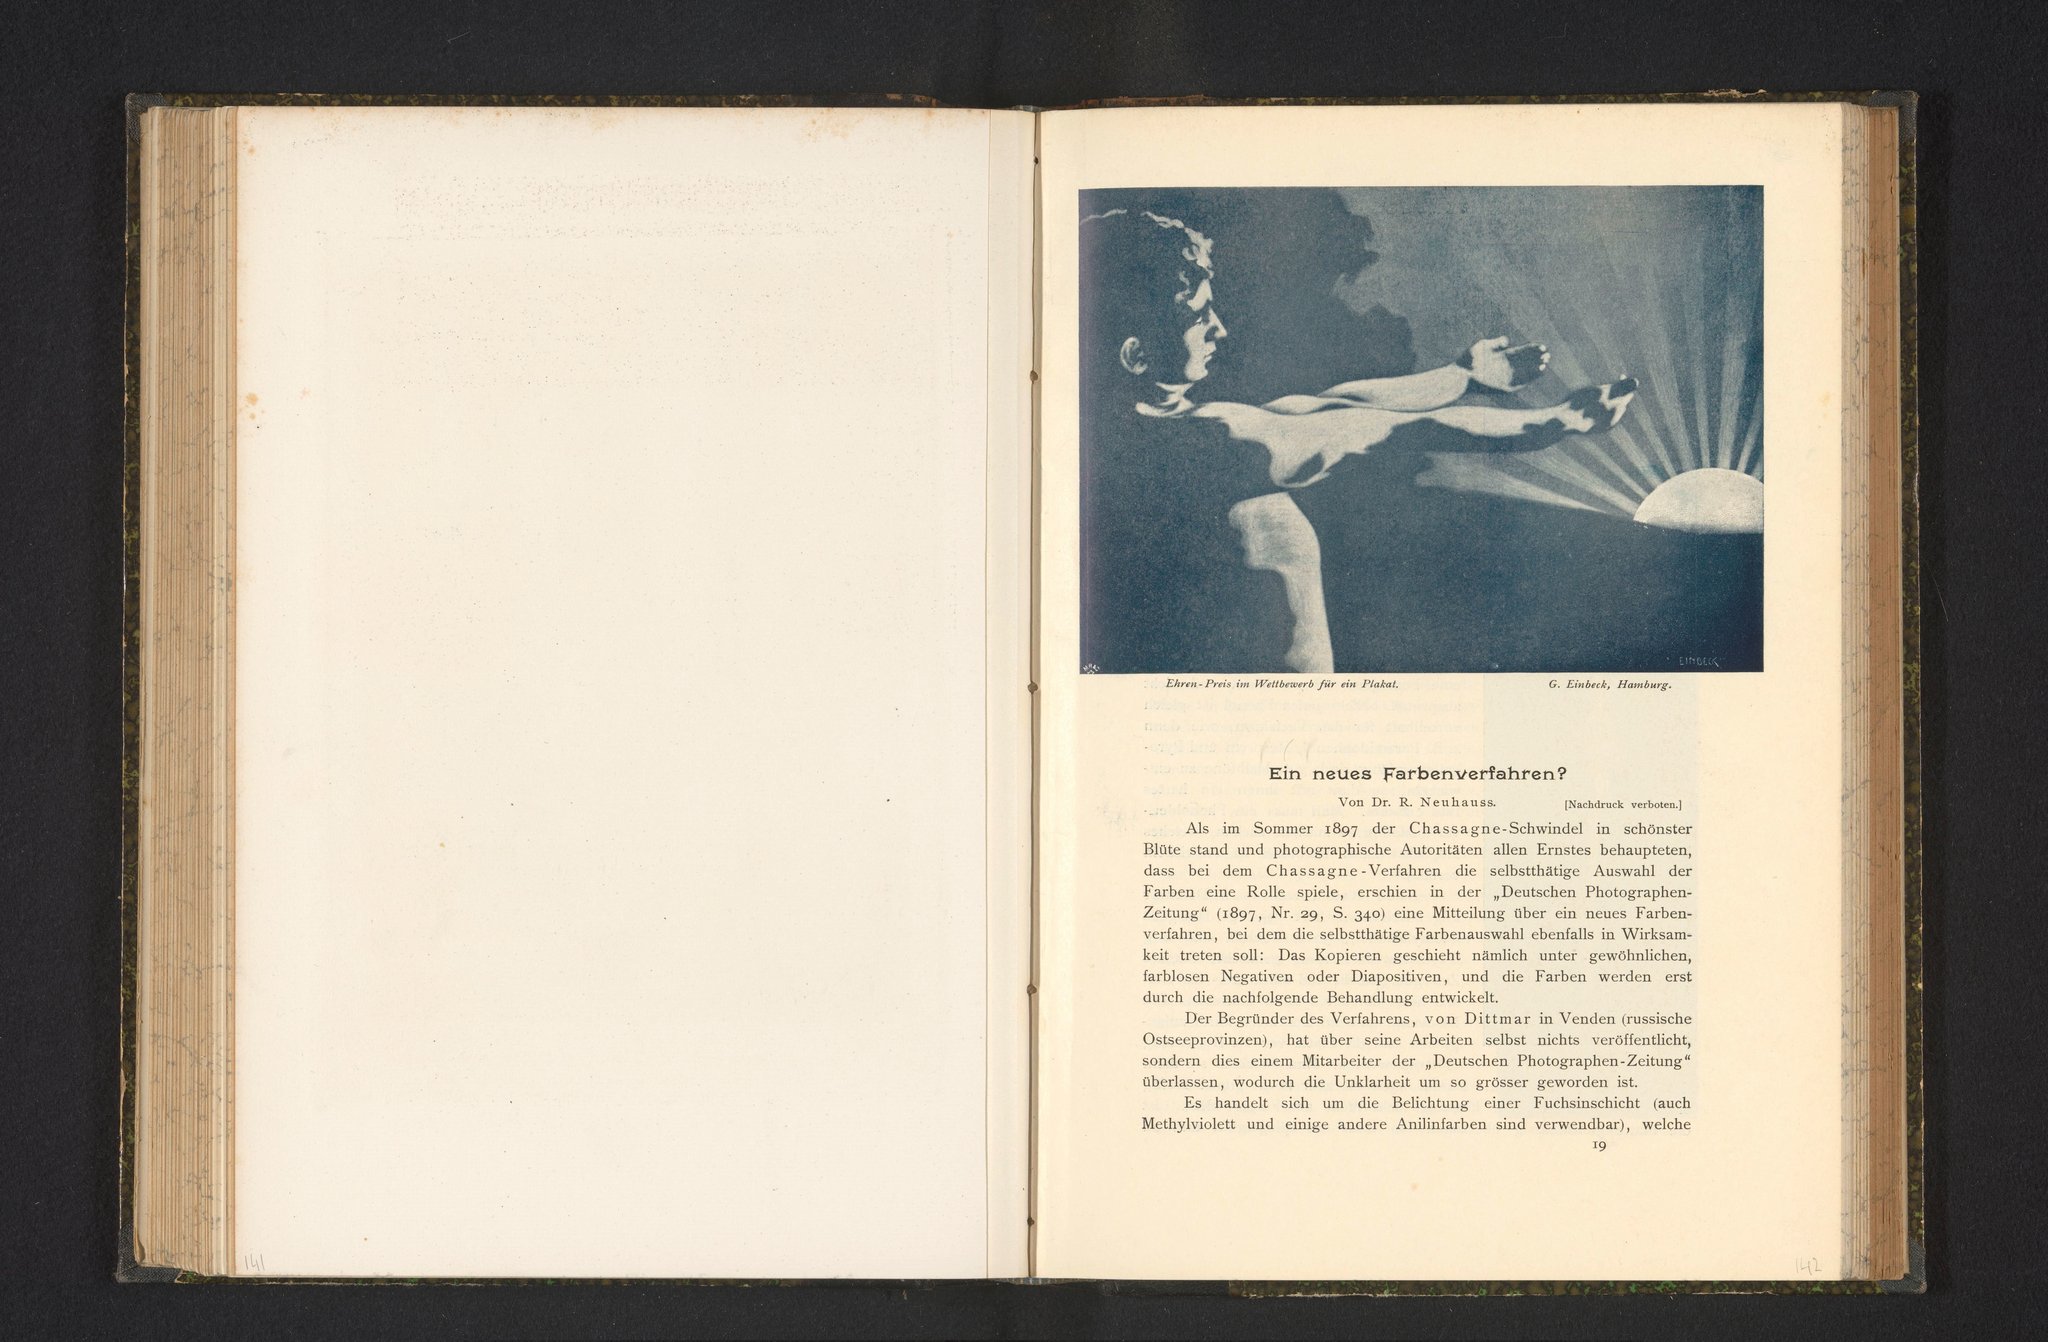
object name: page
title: Ehren - Preis in Wettbewerb für ein Plakat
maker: george einbeck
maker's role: painter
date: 1893-1898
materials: paper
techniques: autotype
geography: berlin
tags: sun as celestial body, postures of the human figure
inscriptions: monogram: ‘MR&C’